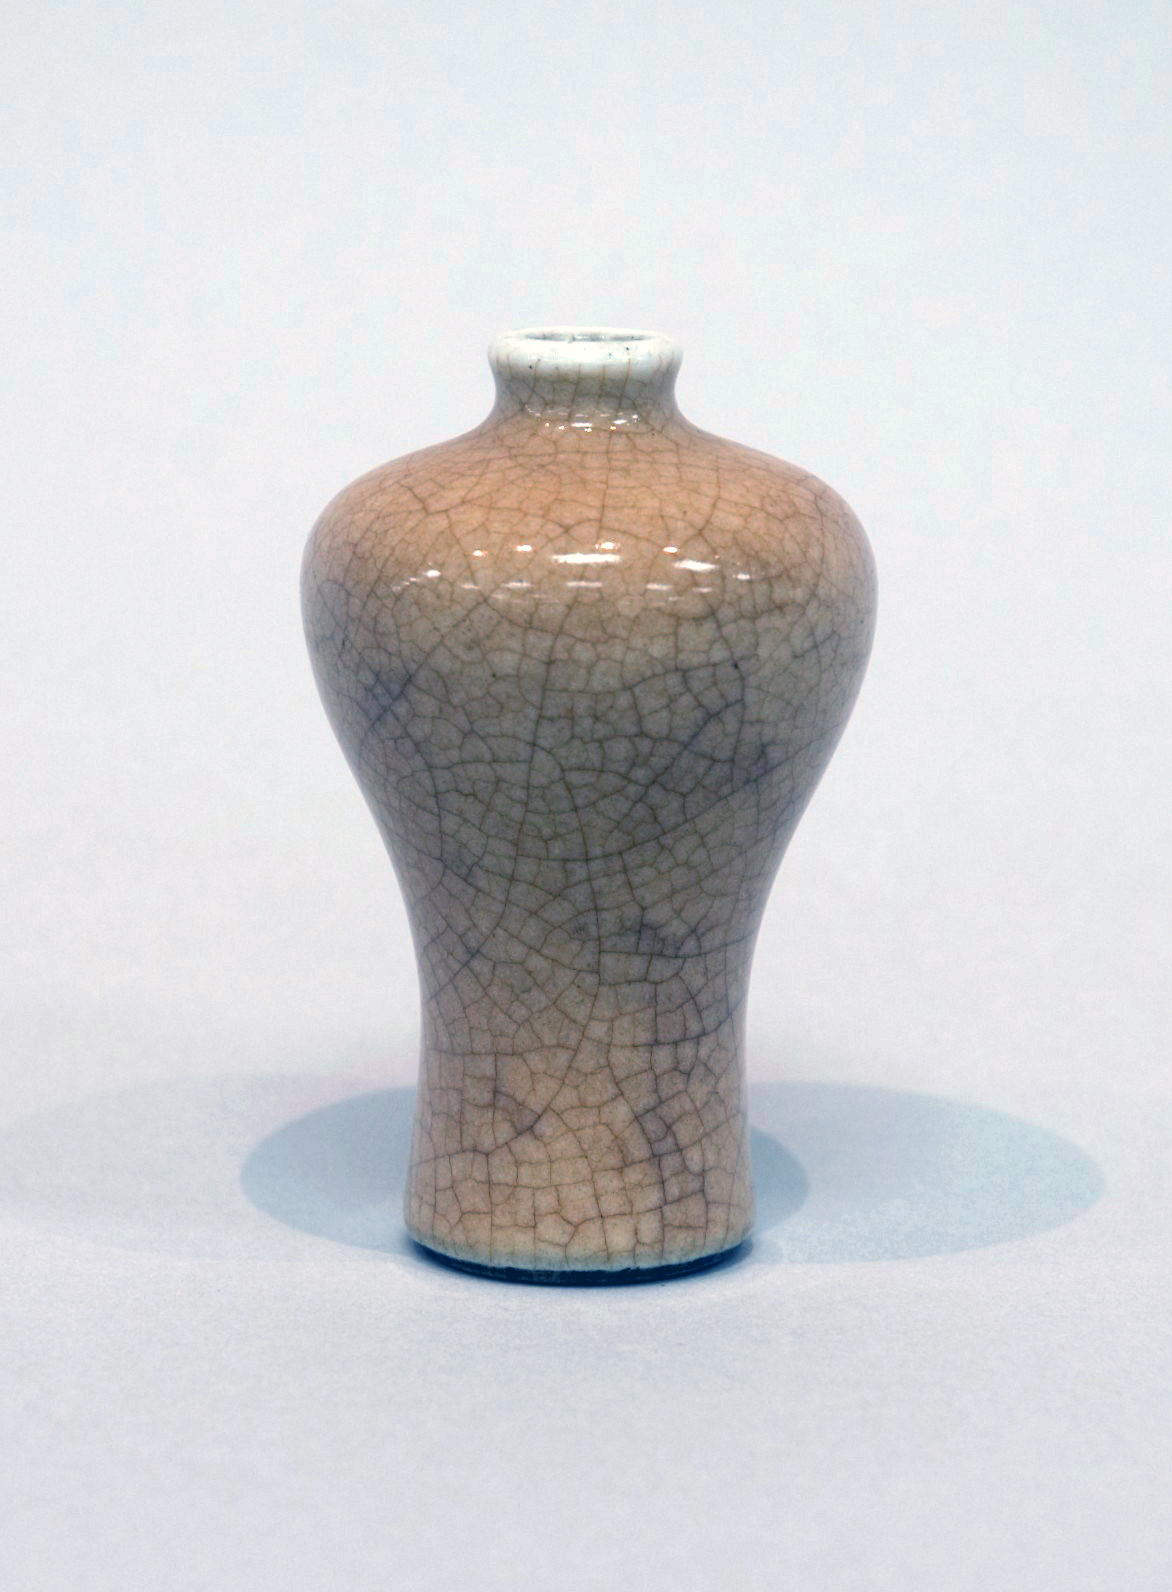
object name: vase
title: Minature Meiping vase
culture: chinese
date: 1701-1800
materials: glaze, porcelain